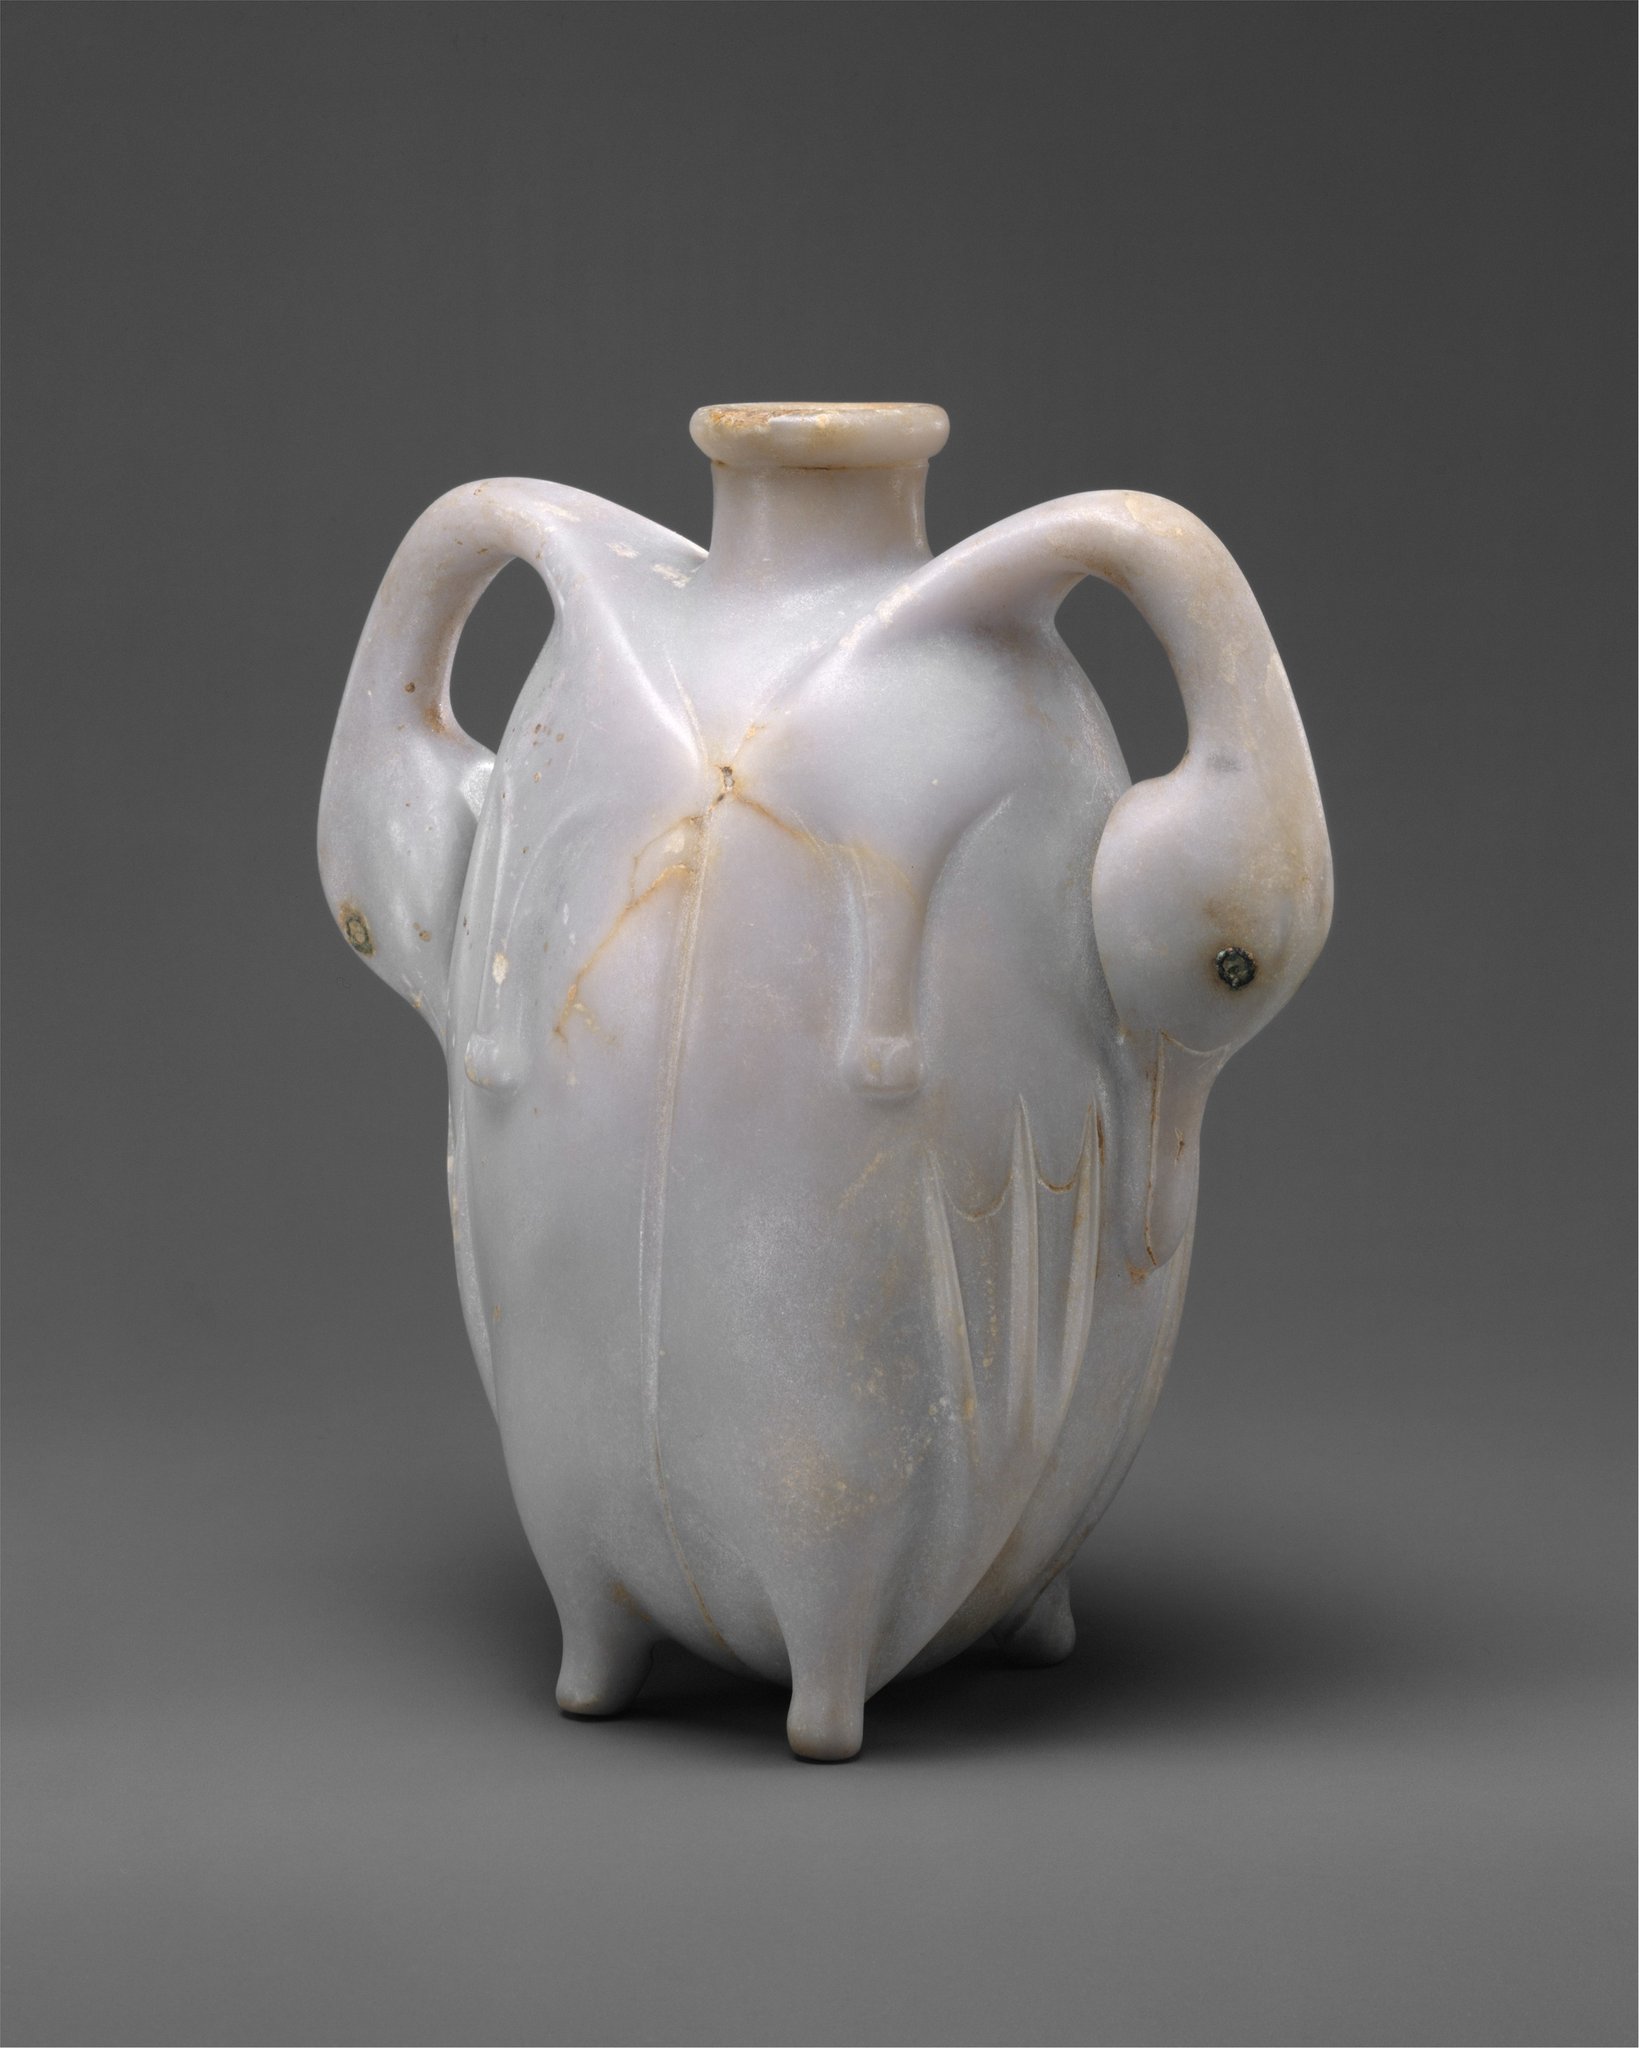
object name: bottle, perfume, trussed duck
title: Perfume Vessel in the Shape of Two Trussed Ducks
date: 1580-1550 BCE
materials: copper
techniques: inlay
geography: egypt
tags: ducks